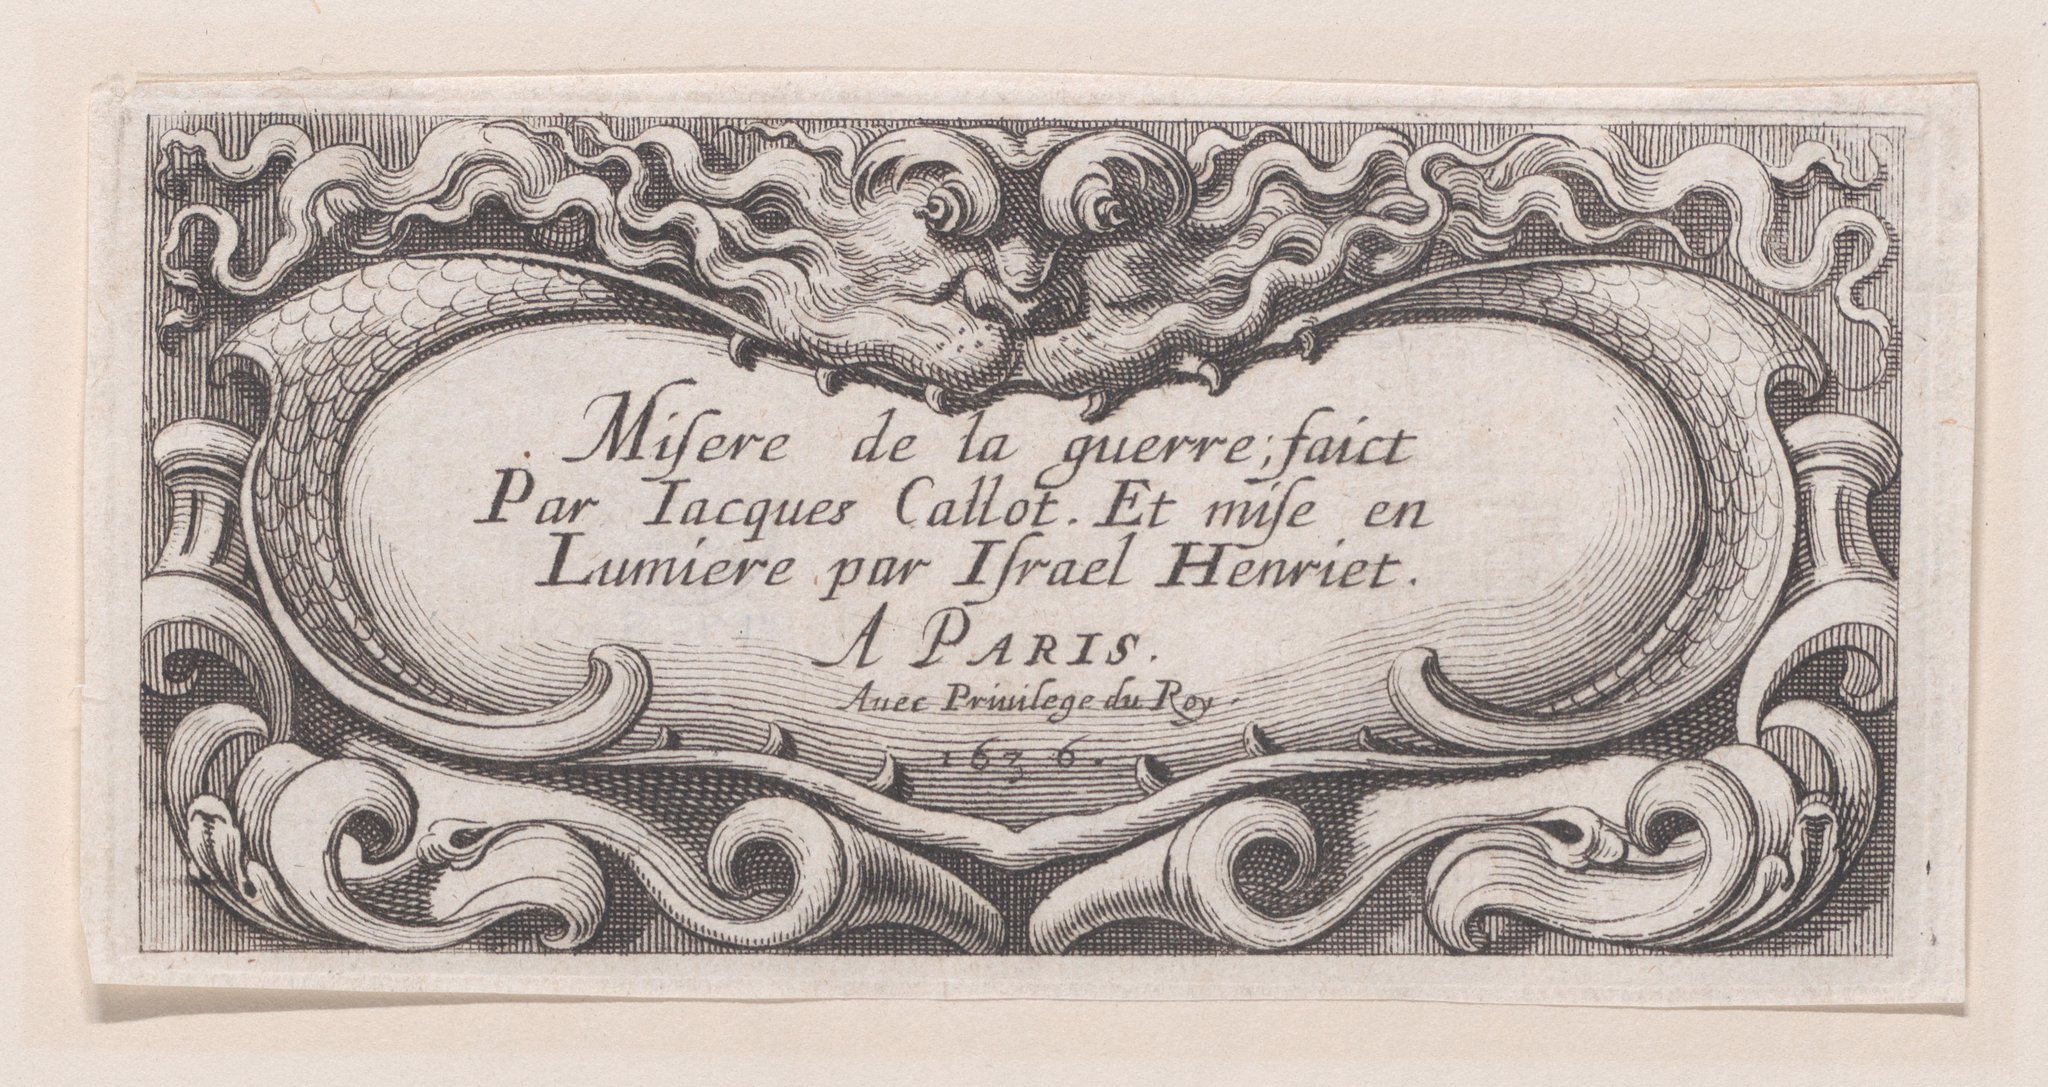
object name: print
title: Frontispiece, from "Les Petites Misères de la Guerre" (The Little Miseries of War)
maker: abraham bosse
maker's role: artist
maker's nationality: french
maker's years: 1602-1676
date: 1636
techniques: etching